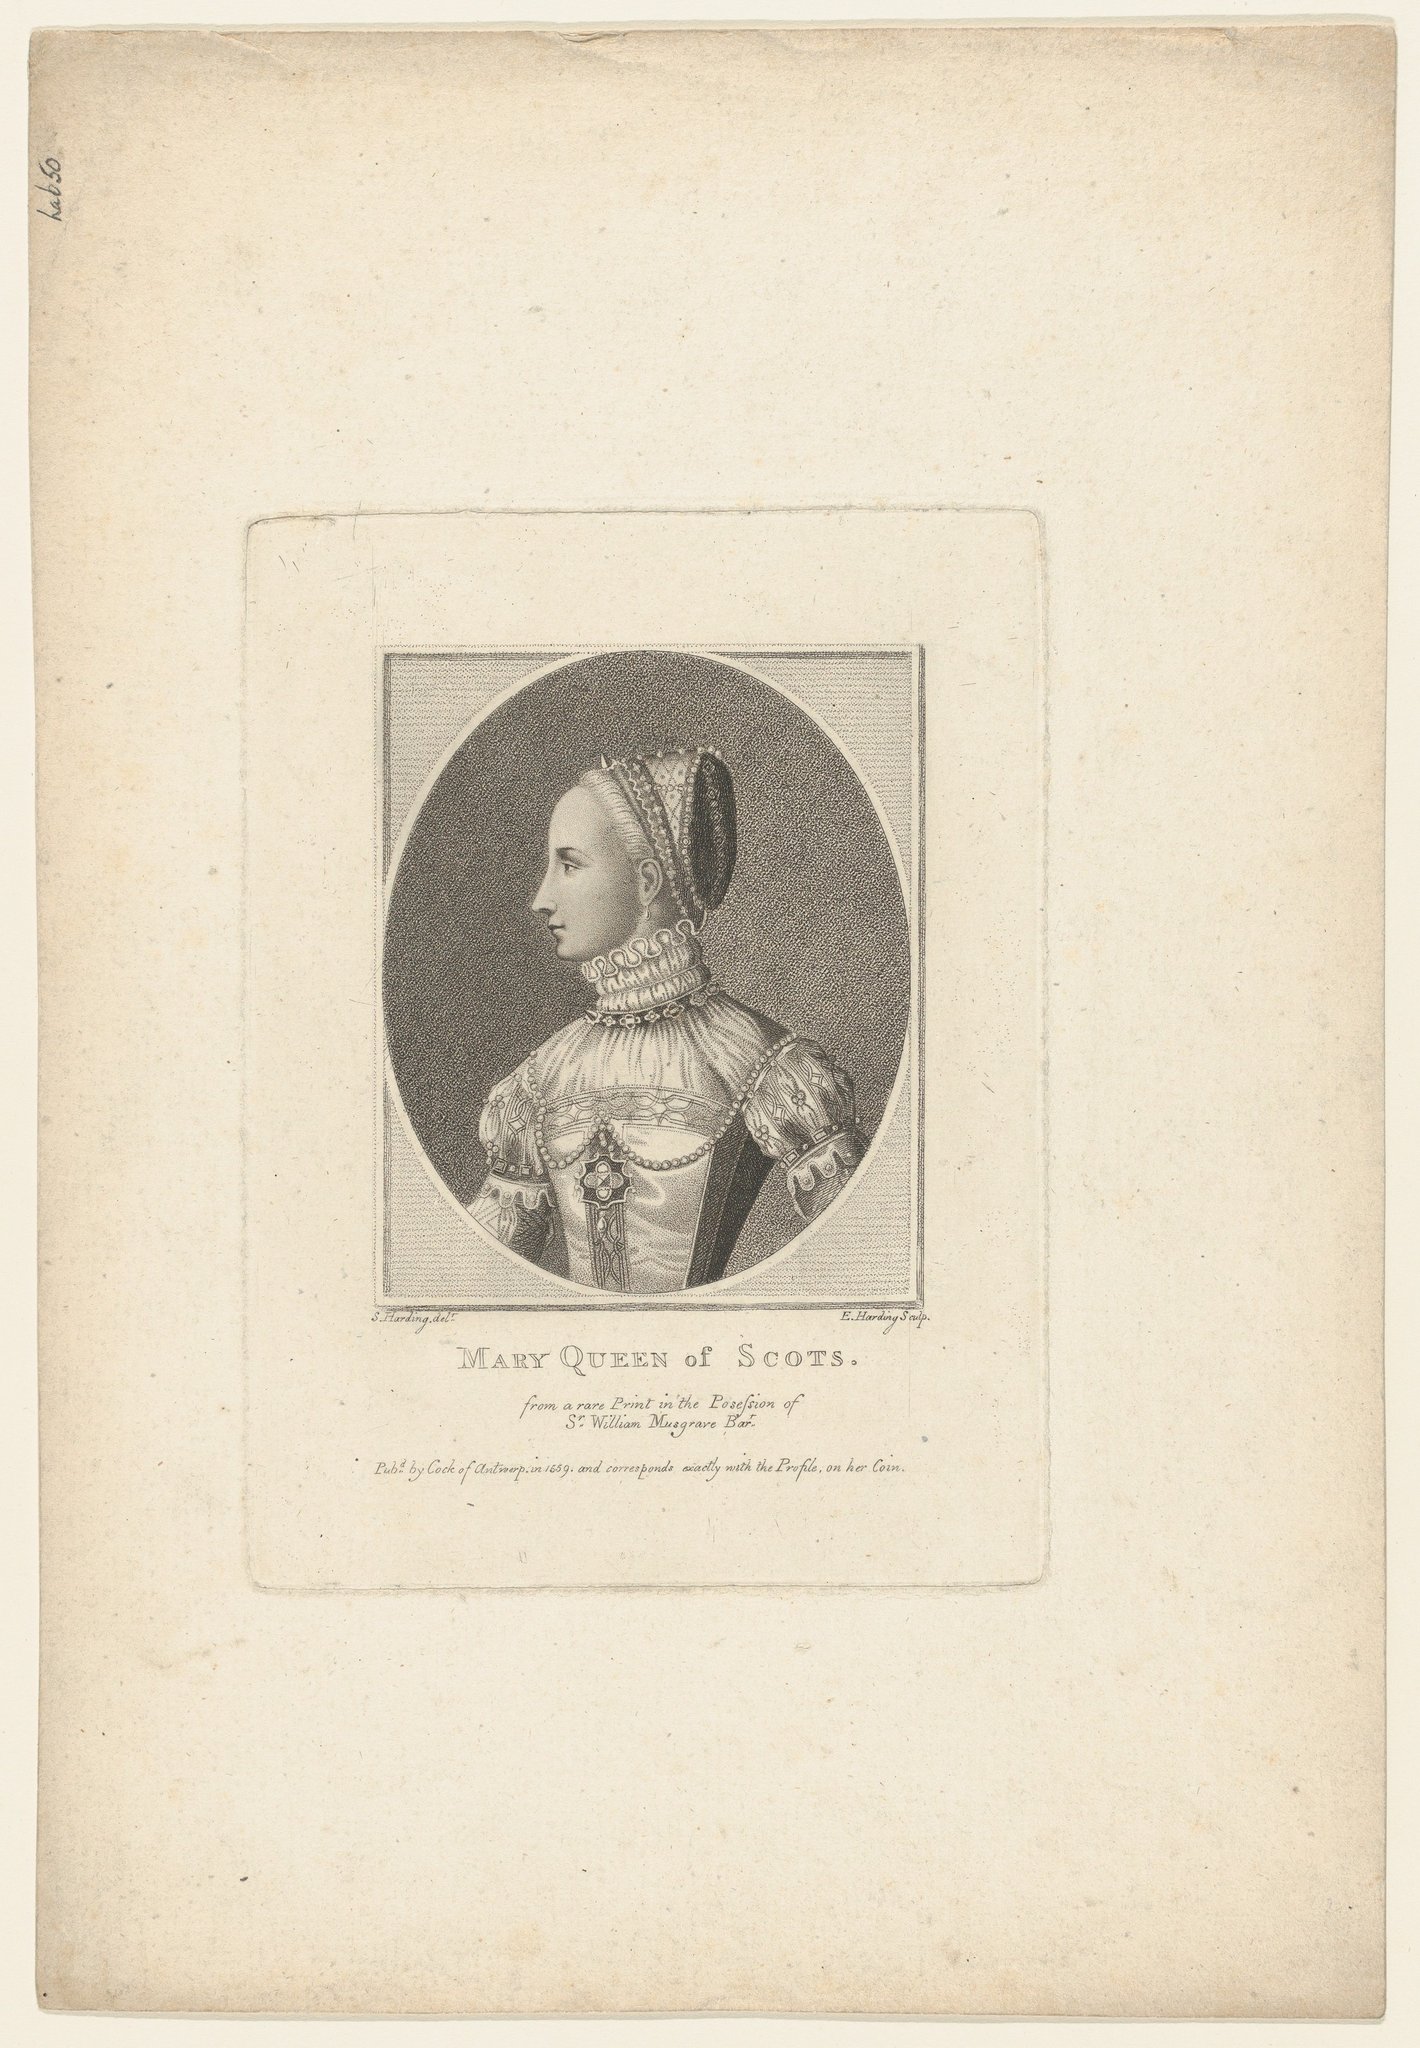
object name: print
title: Mary, Queen of Scots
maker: edward harding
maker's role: engraver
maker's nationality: british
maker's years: 1755-1840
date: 1793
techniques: engraving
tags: queens,mary queen of scots